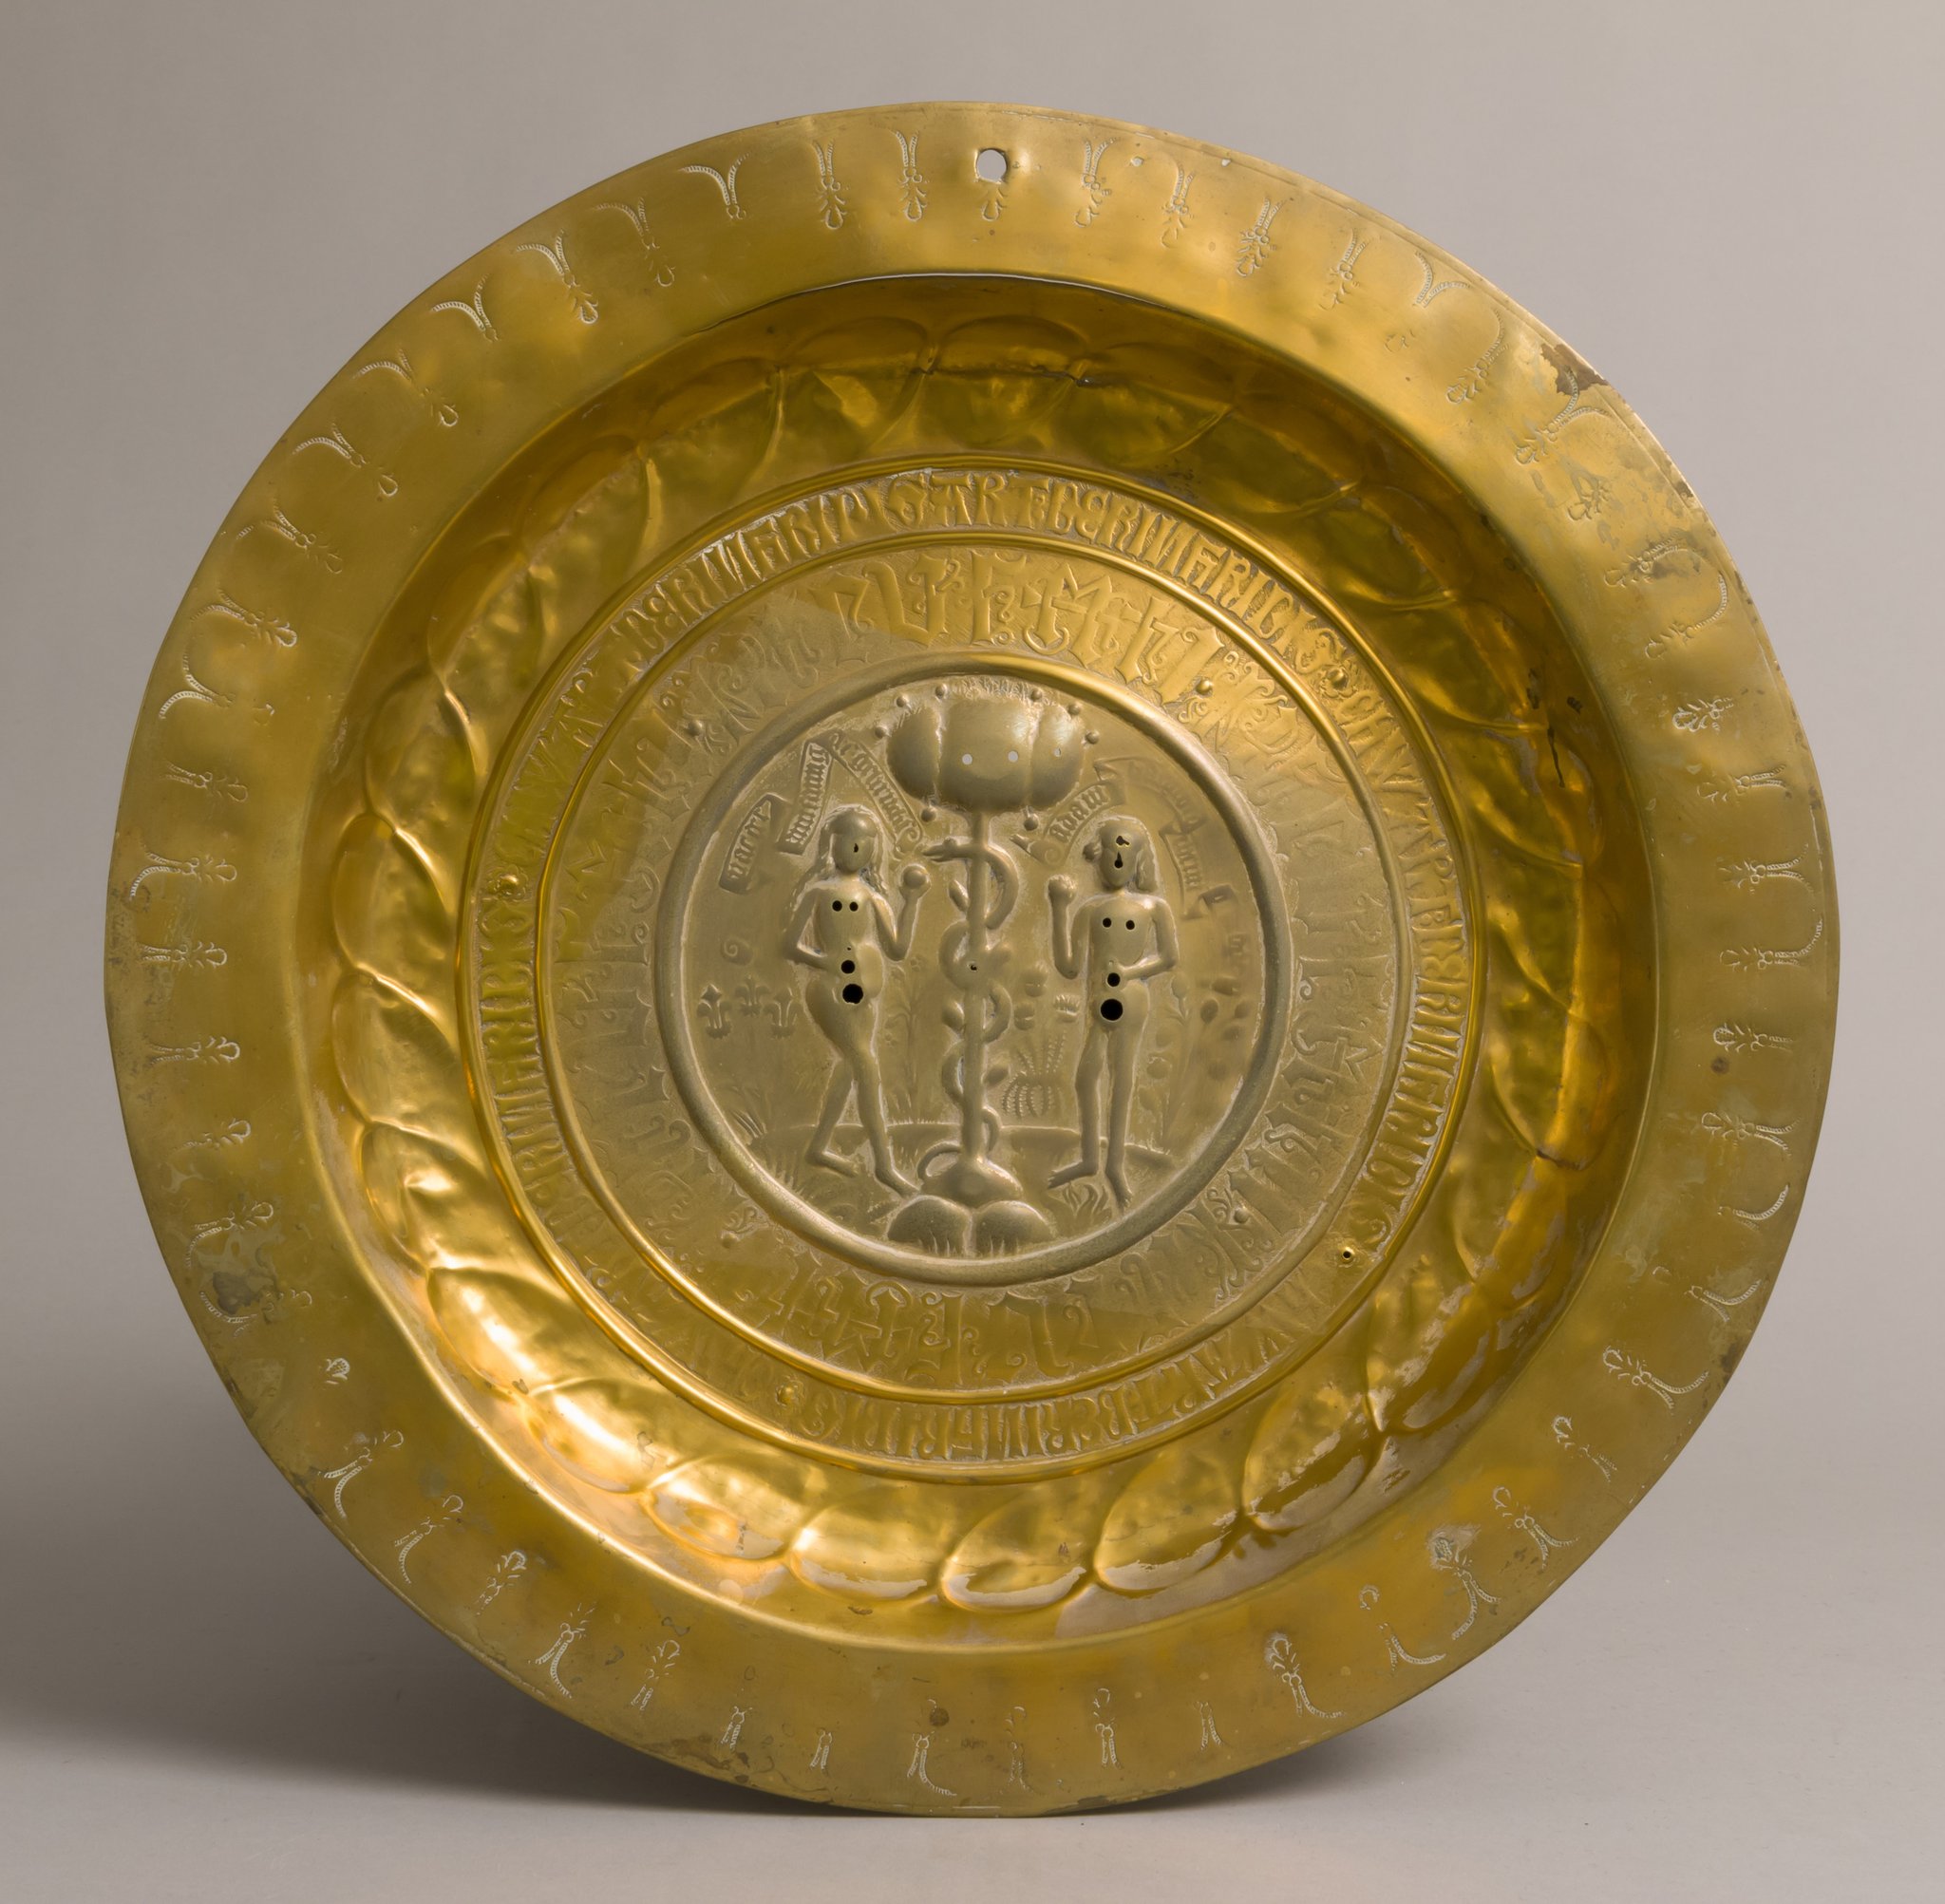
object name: dish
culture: german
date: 1501-1533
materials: brass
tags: snakes,adam,eve